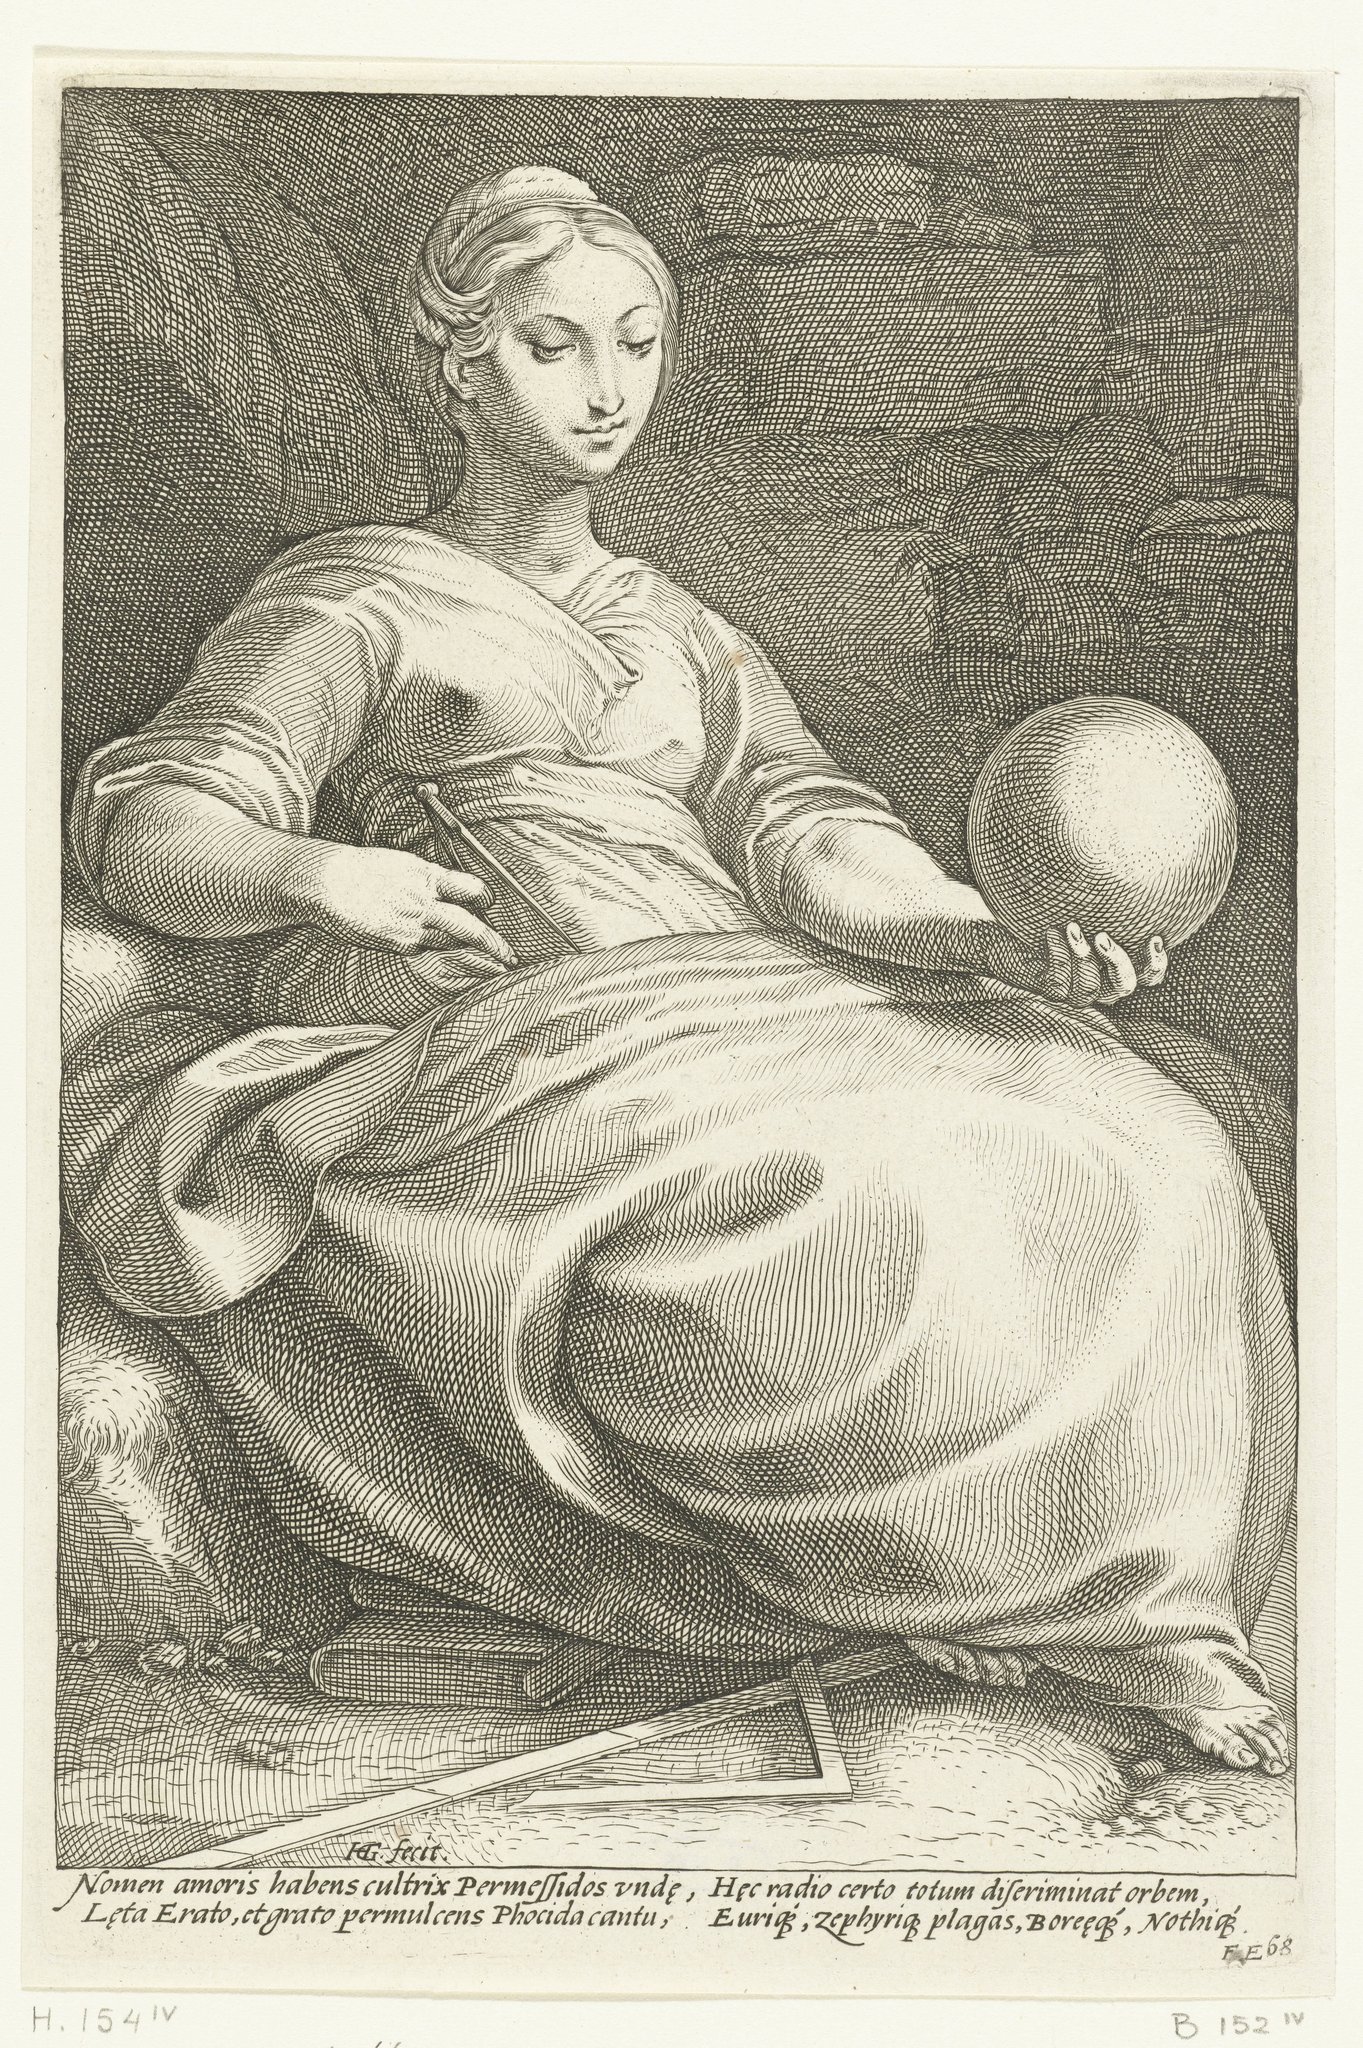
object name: print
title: De negen muzen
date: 1592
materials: paper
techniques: engraving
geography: haarlem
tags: erato (one of the muses); 'erato' (ripa)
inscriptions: collector's mark: Lugt 2228a, signature: ‘F.E.’, signature: ‘HG. fecit.’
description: Een serie van negen muzen. Met Latijnse tekst van Franco Estius in de marge onder de prent.